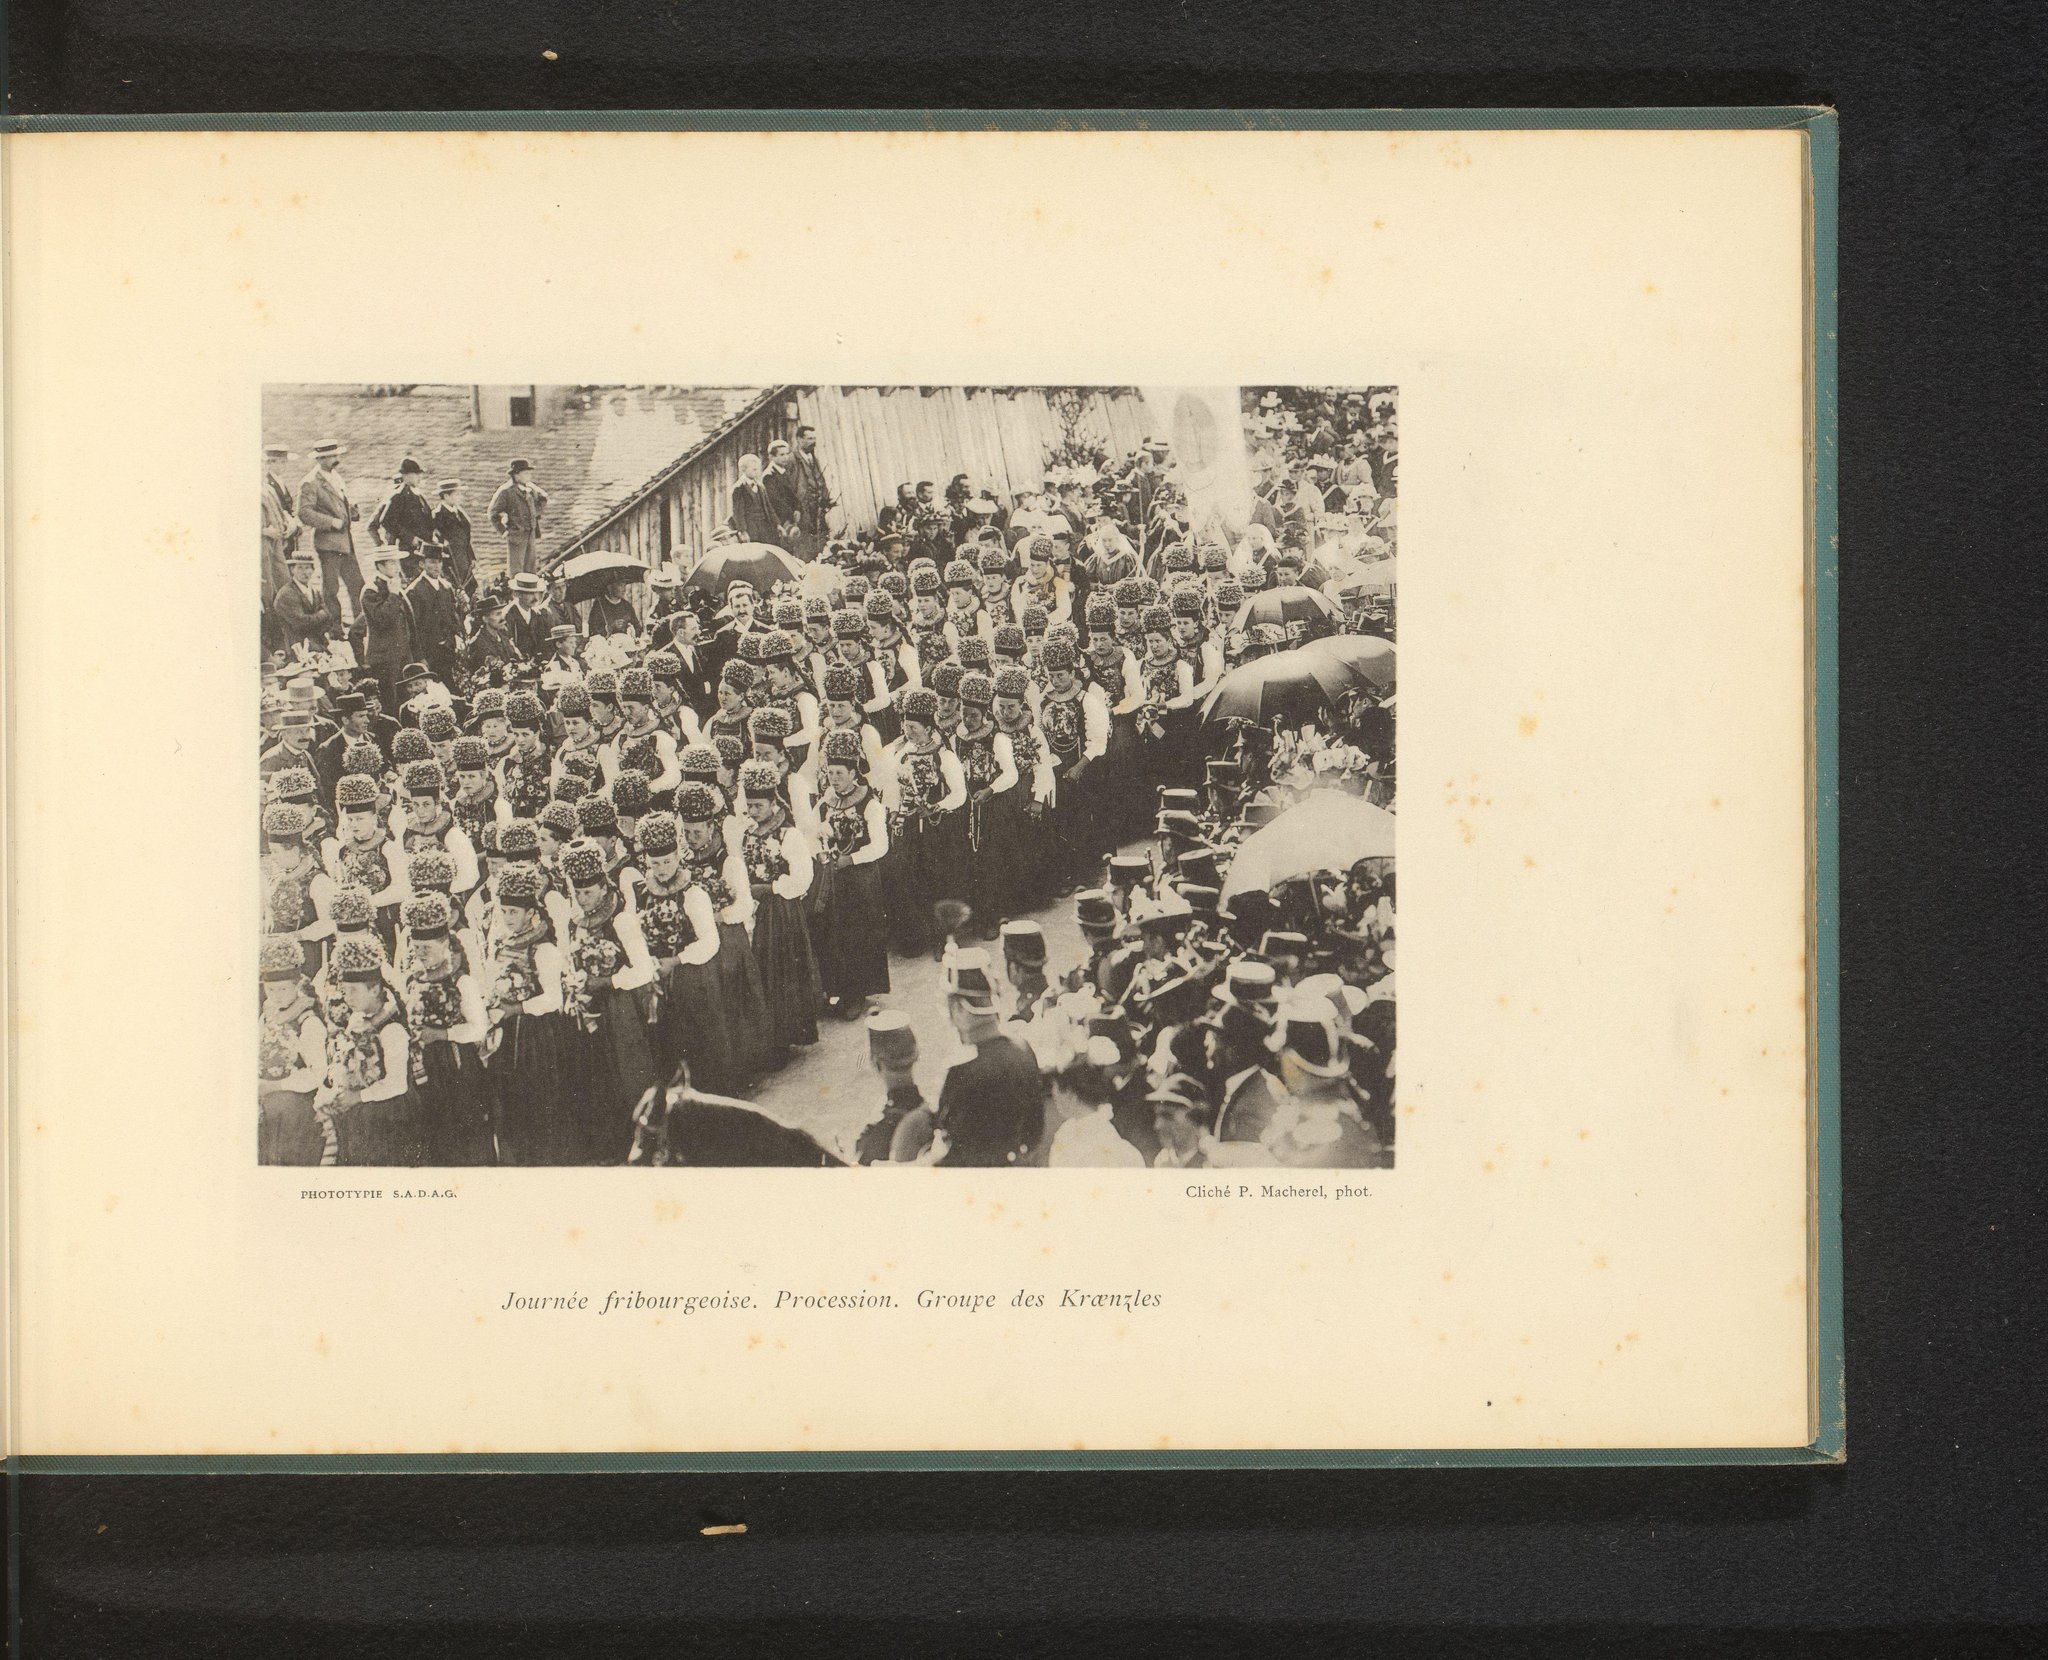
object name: photomechanical print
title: Processie in Fribourg, vermoedelijk ter herdenking van de sterfdag van Petrus Canisius in 1597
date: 1897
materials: paper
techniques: photograph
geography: fribourg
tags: public festivities, procession ~ christian religion